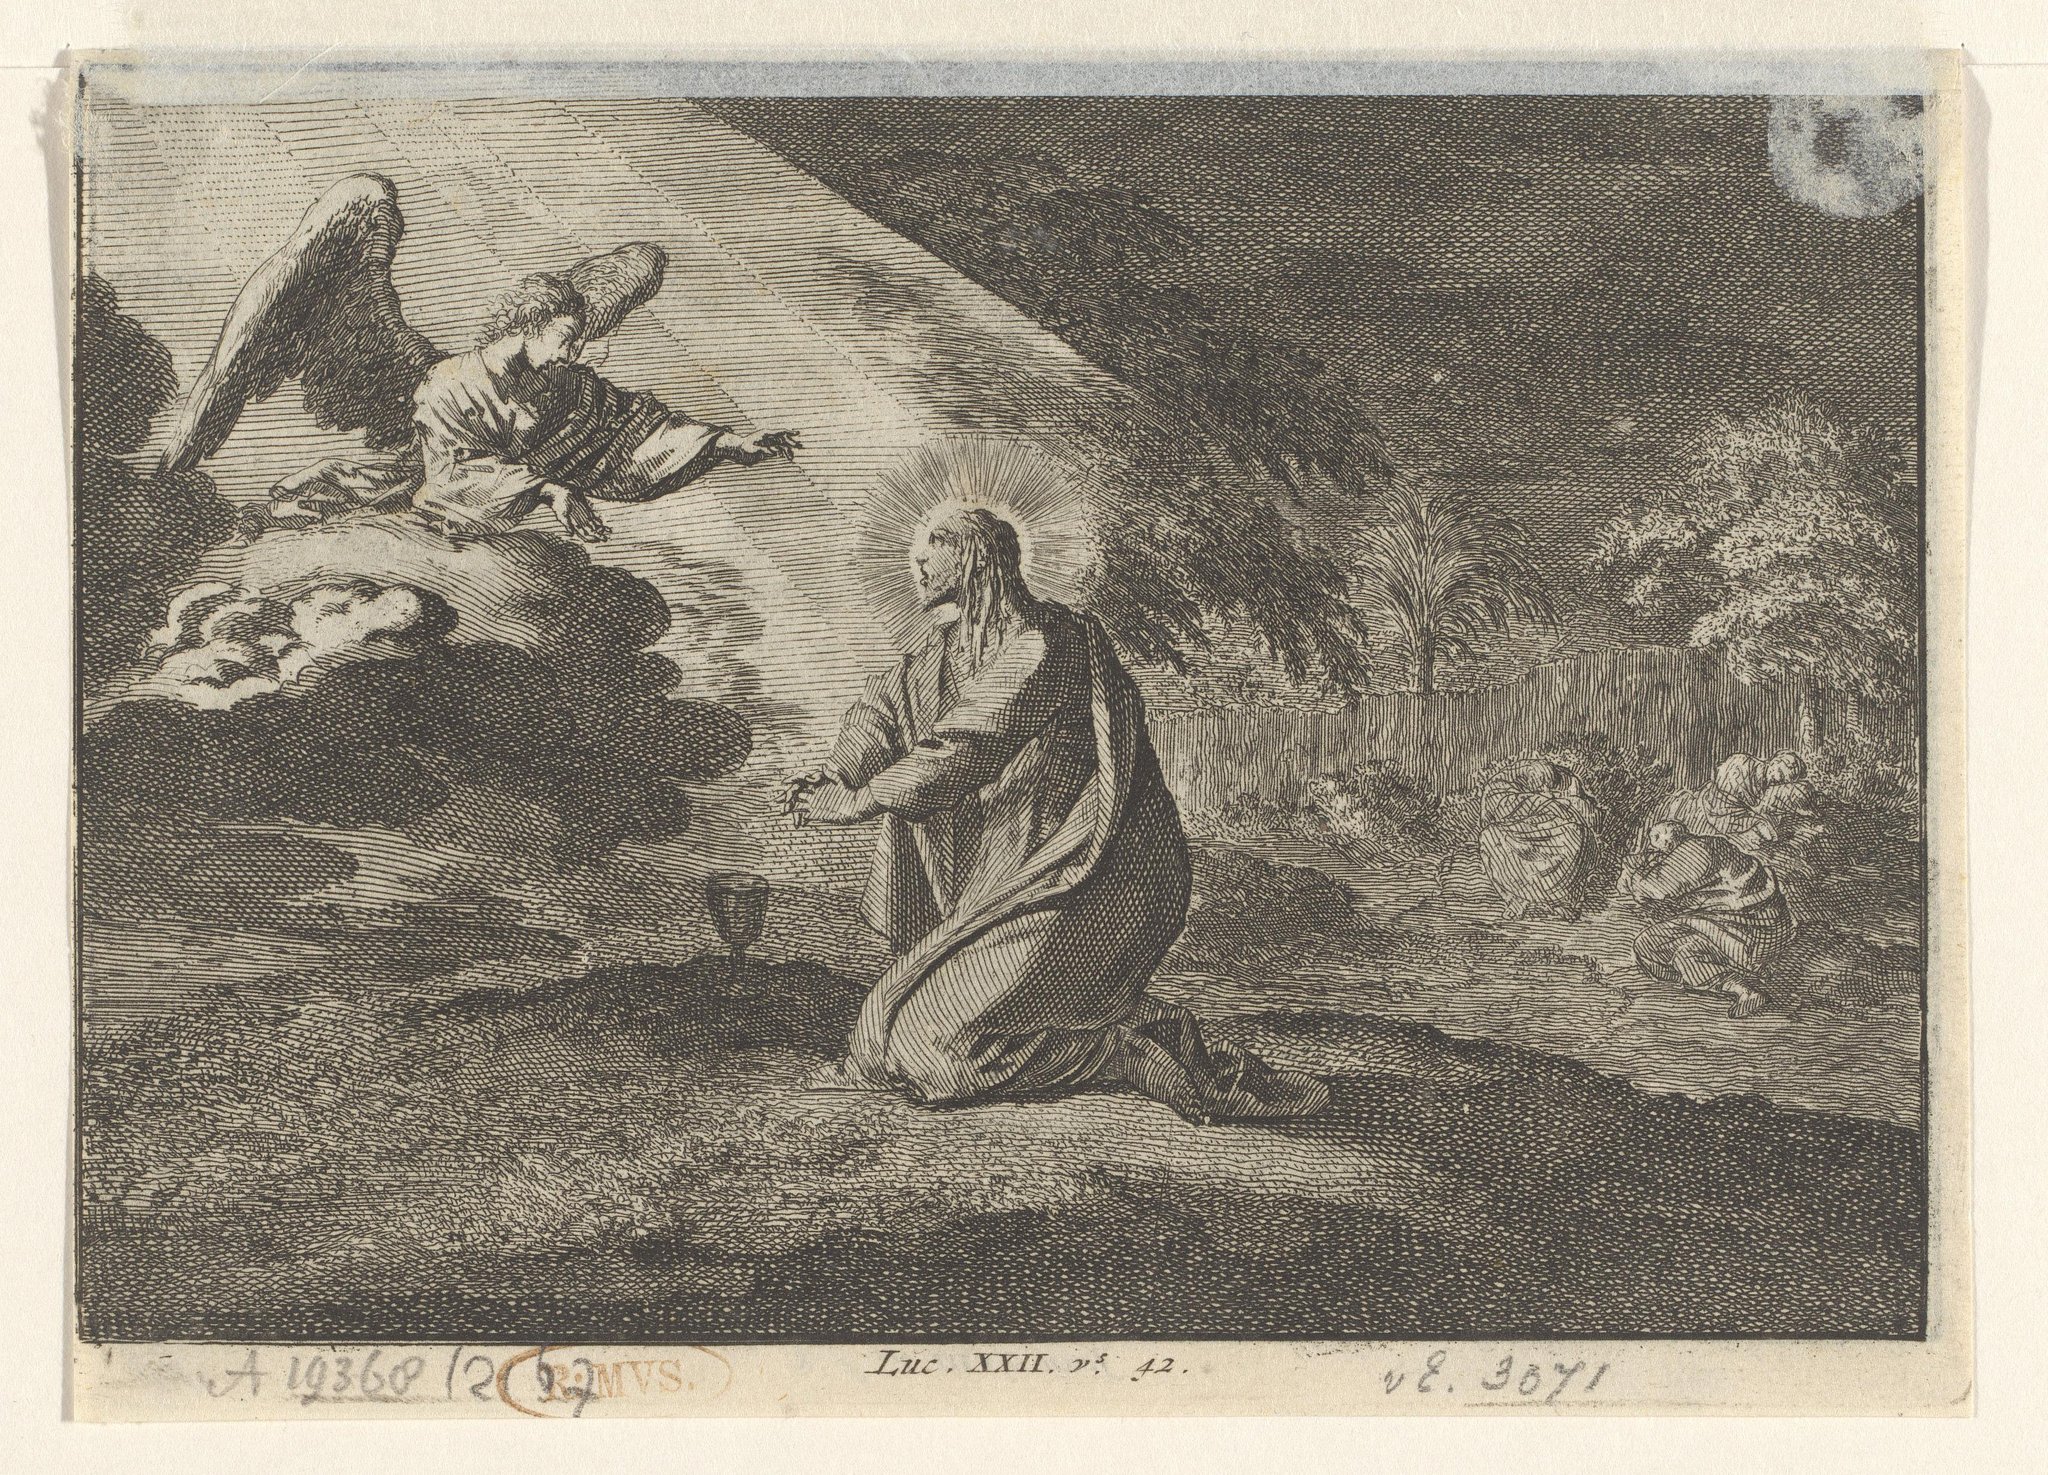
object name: print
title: Christus in de hof van Getsemane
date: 1703-1762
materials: paper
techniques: etching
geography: amsterdam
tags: agony of christ: to comfort him one or more angels appear to christ with chalice and/or cross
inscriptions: collector's mark: Lugt 2228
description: De prent komt een eerste keer voor als boekillustratie voor David Martin. Historie des Ouden en Nieuwen Testaments. Amsterdam, Pieter Mortier, 1703. Deel II. De boekillustraties voor de Mortierbijbel hebben verschillende staten en kopieën, waarbij de chronologische volgorde moeilijk te achterhalen valt. Als boekillustraties werden ze bovendien herhaaldelijk opnieuw gebruikt voor andere boekwerken.